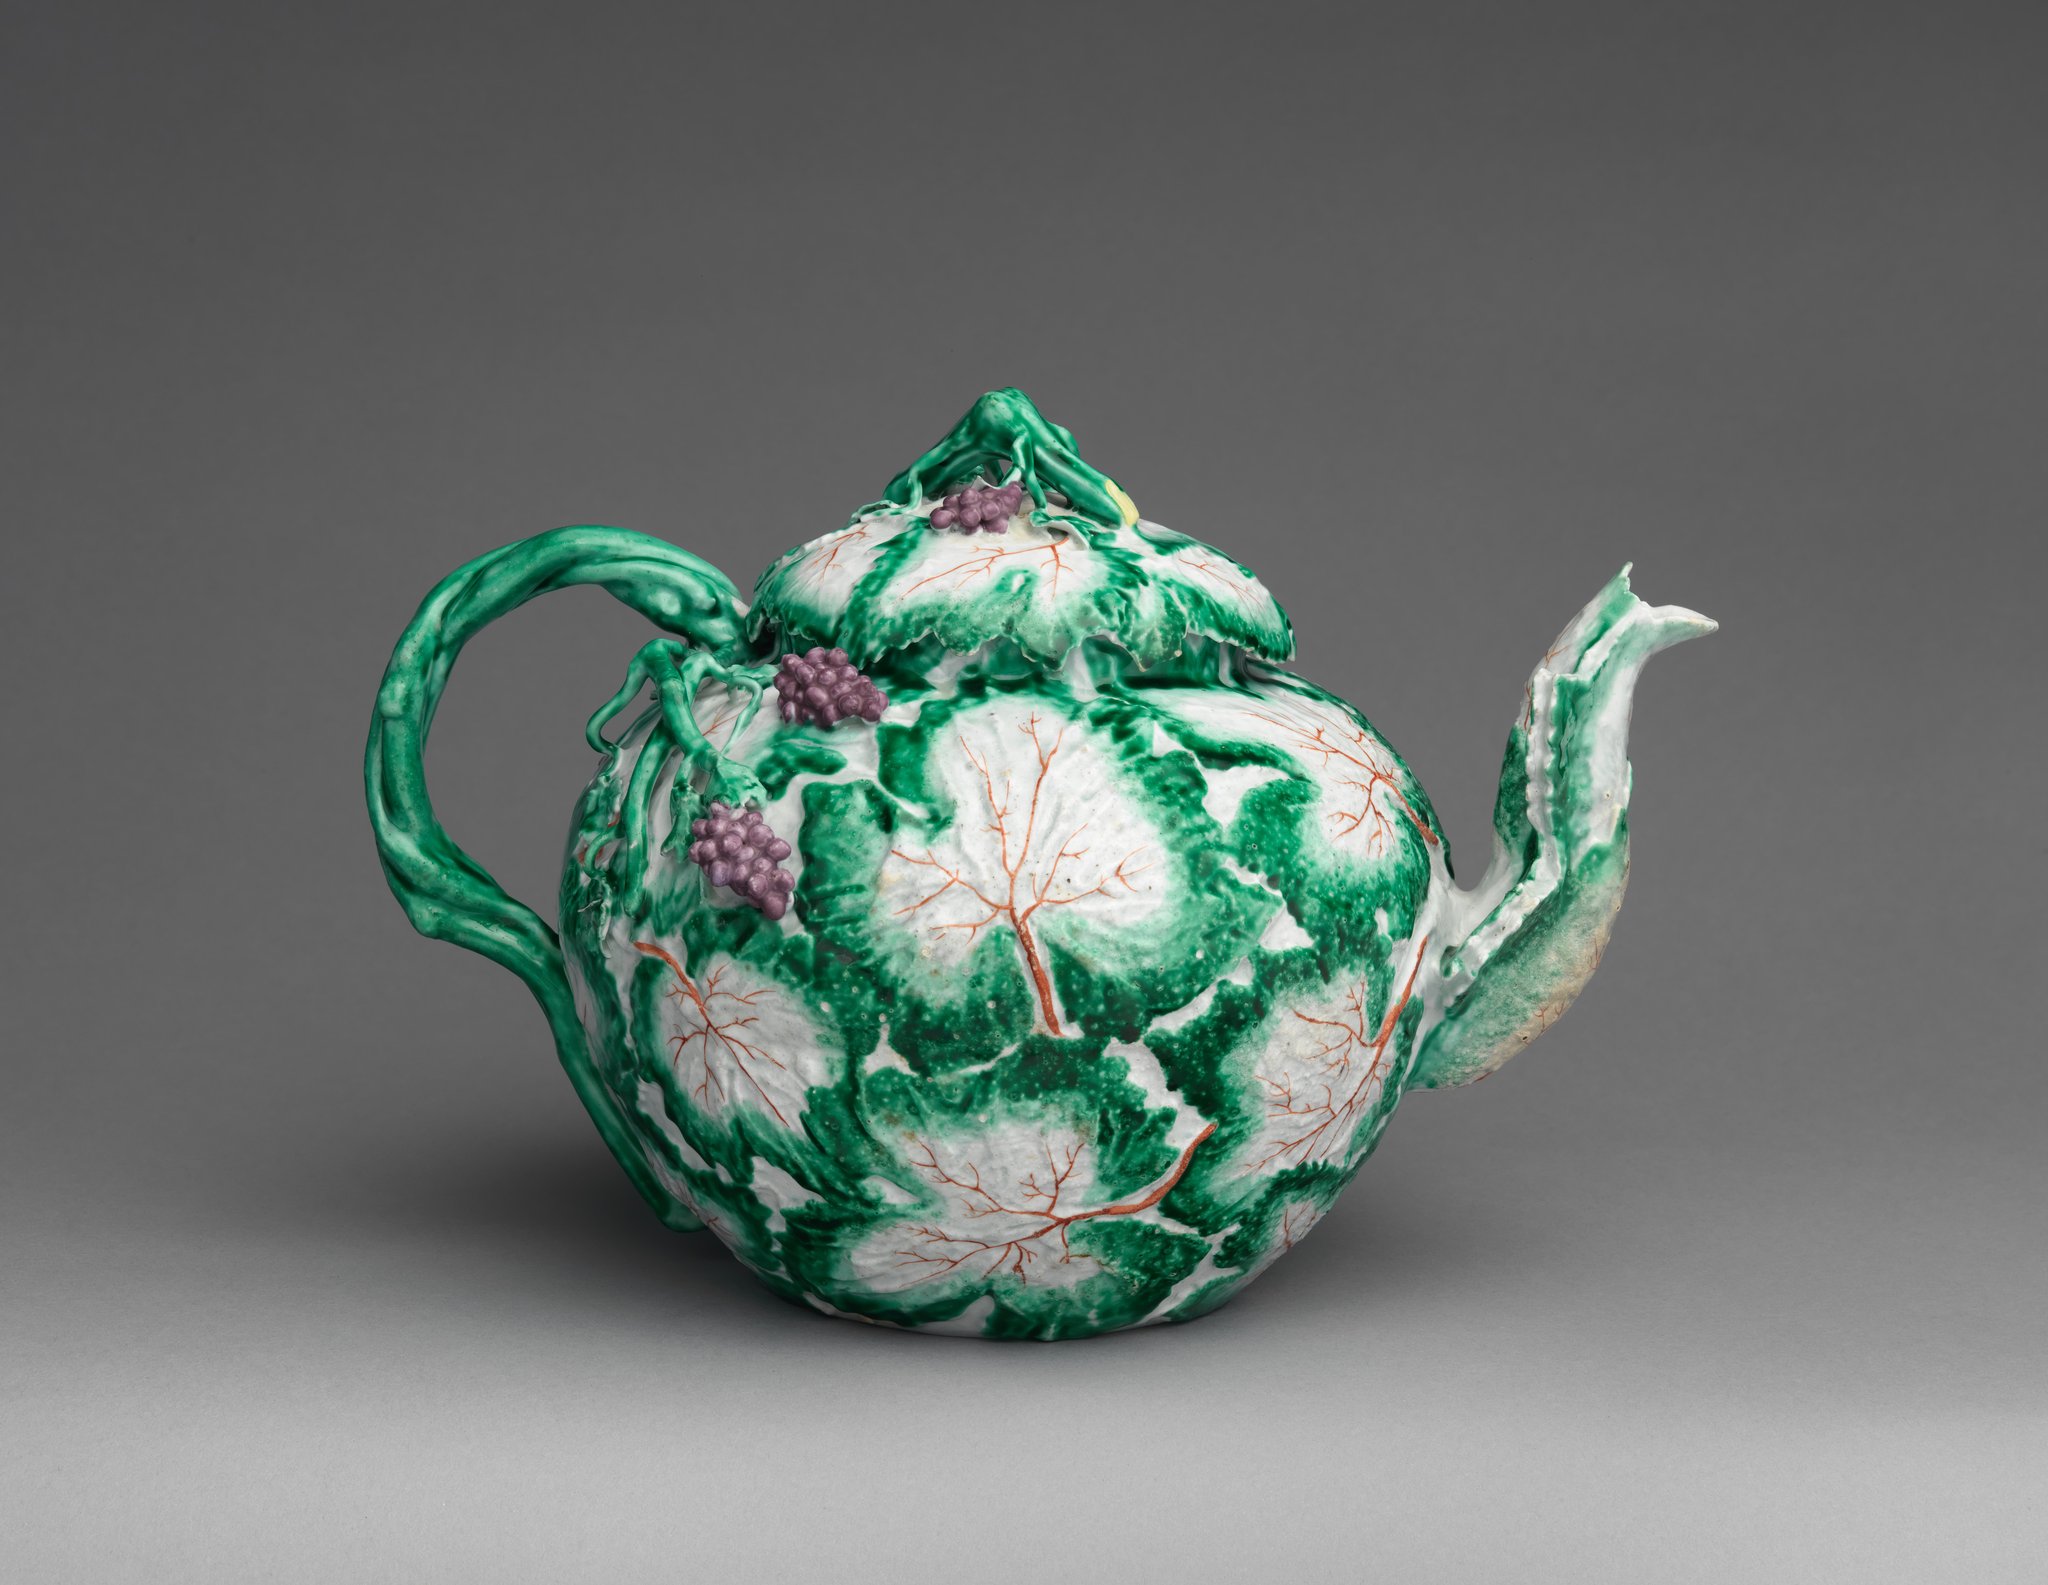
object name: punch pot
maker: longton hall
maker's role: maker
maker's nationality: british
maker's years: 1744-1760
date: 1755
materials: enamel, soft paste porcelain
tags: grapes